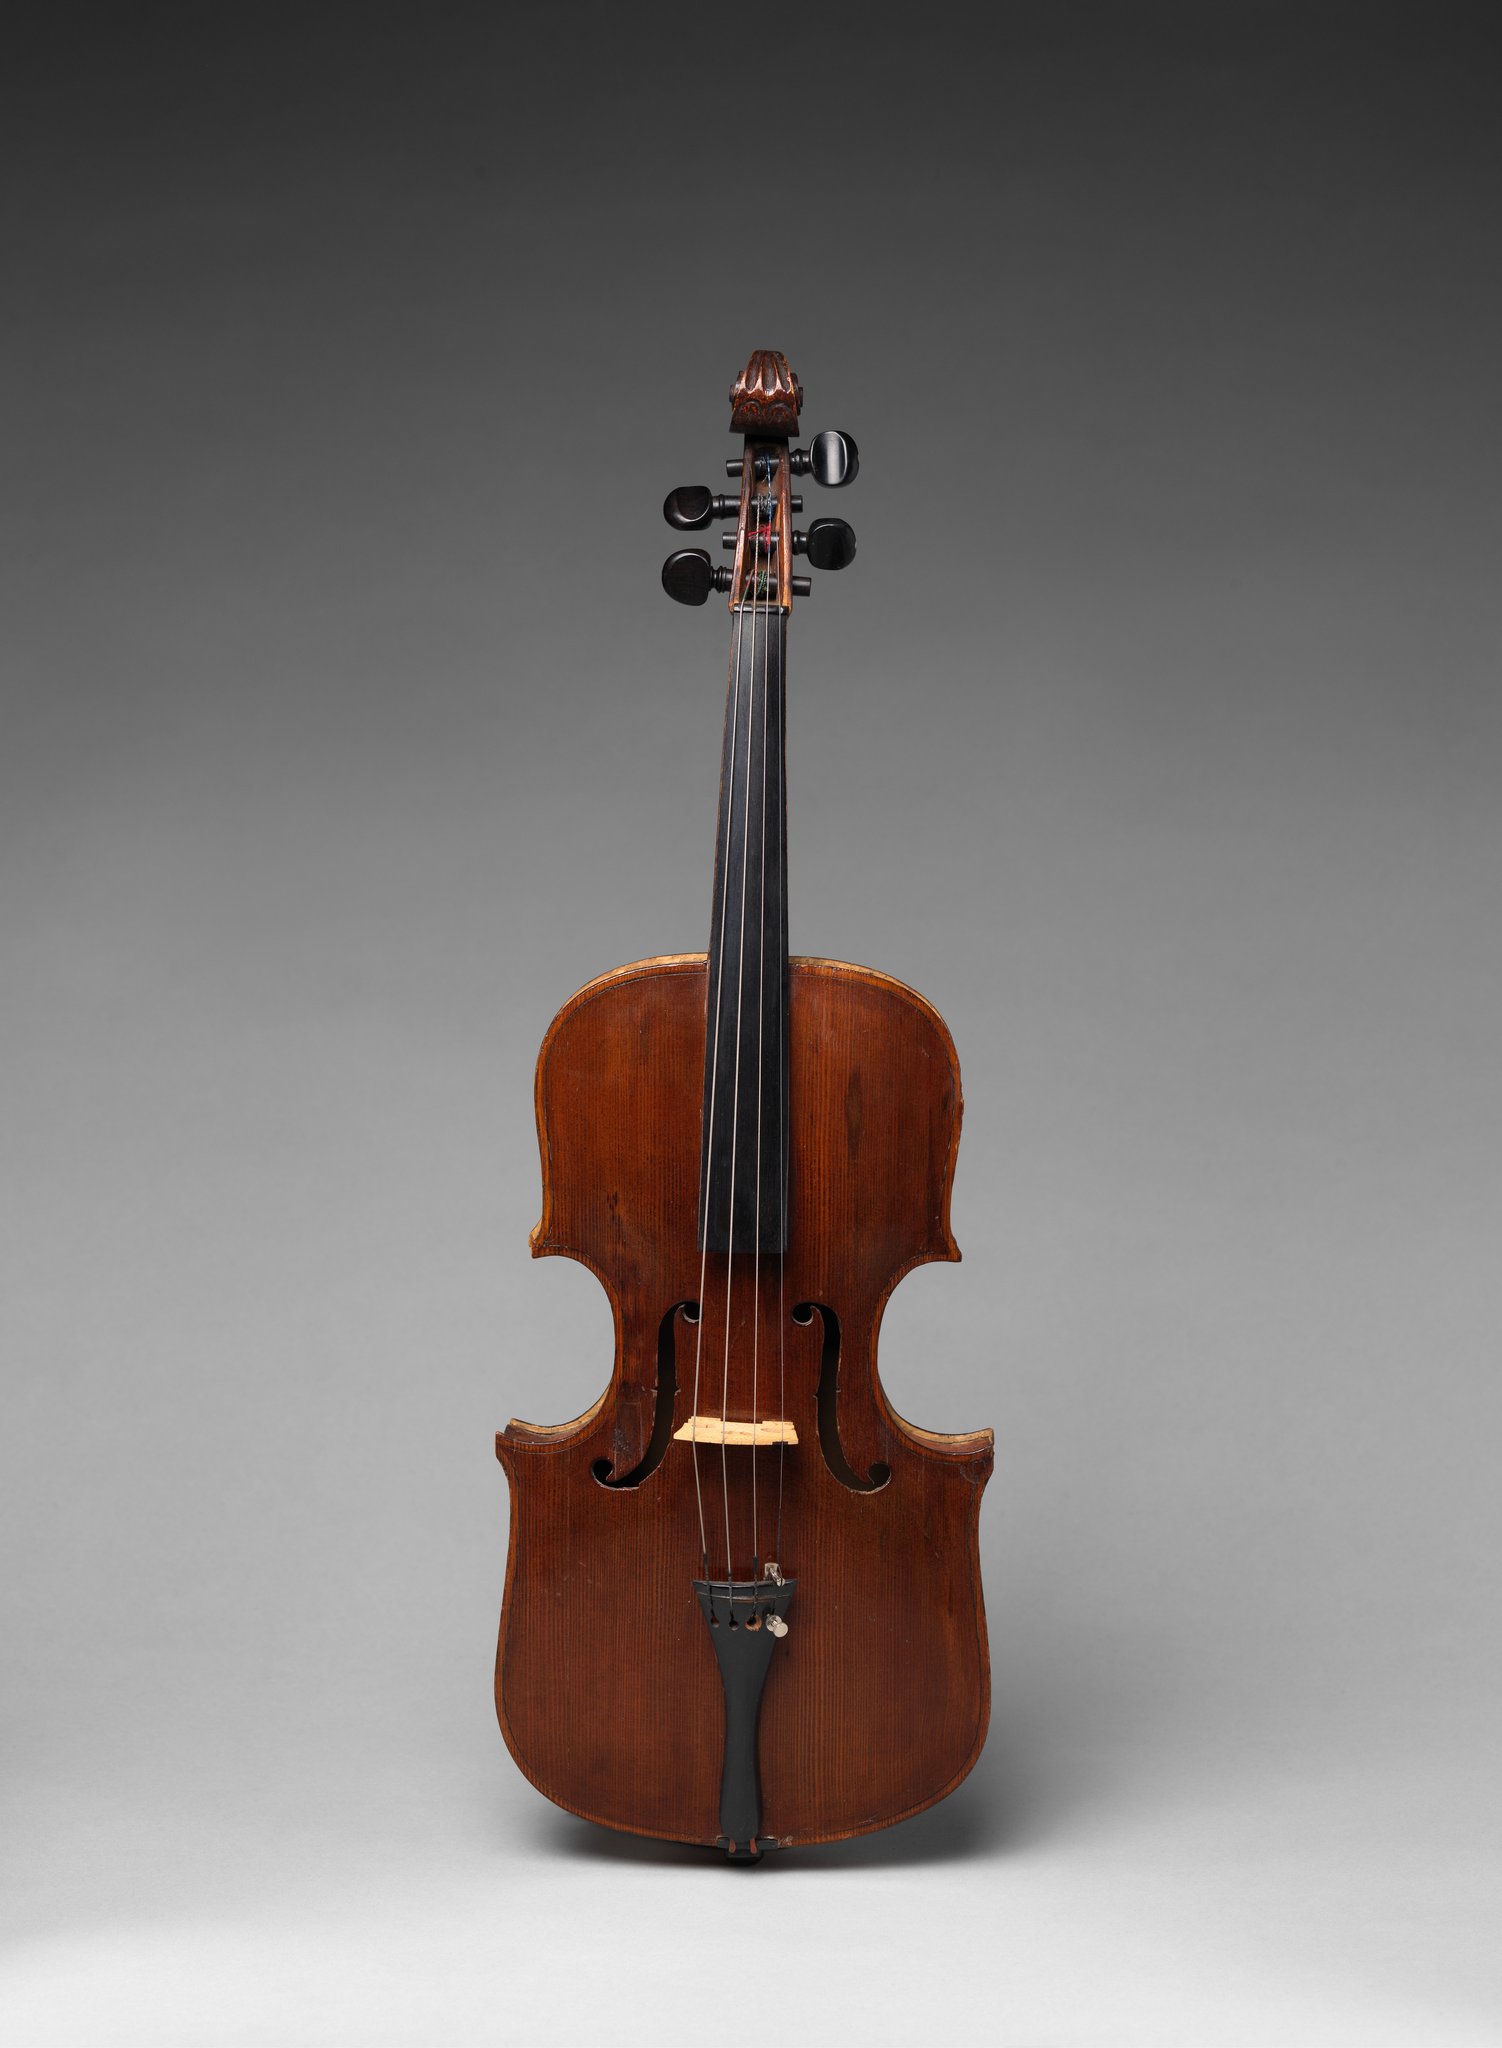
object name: violin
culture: american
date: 1867-1933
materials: wood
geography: united states